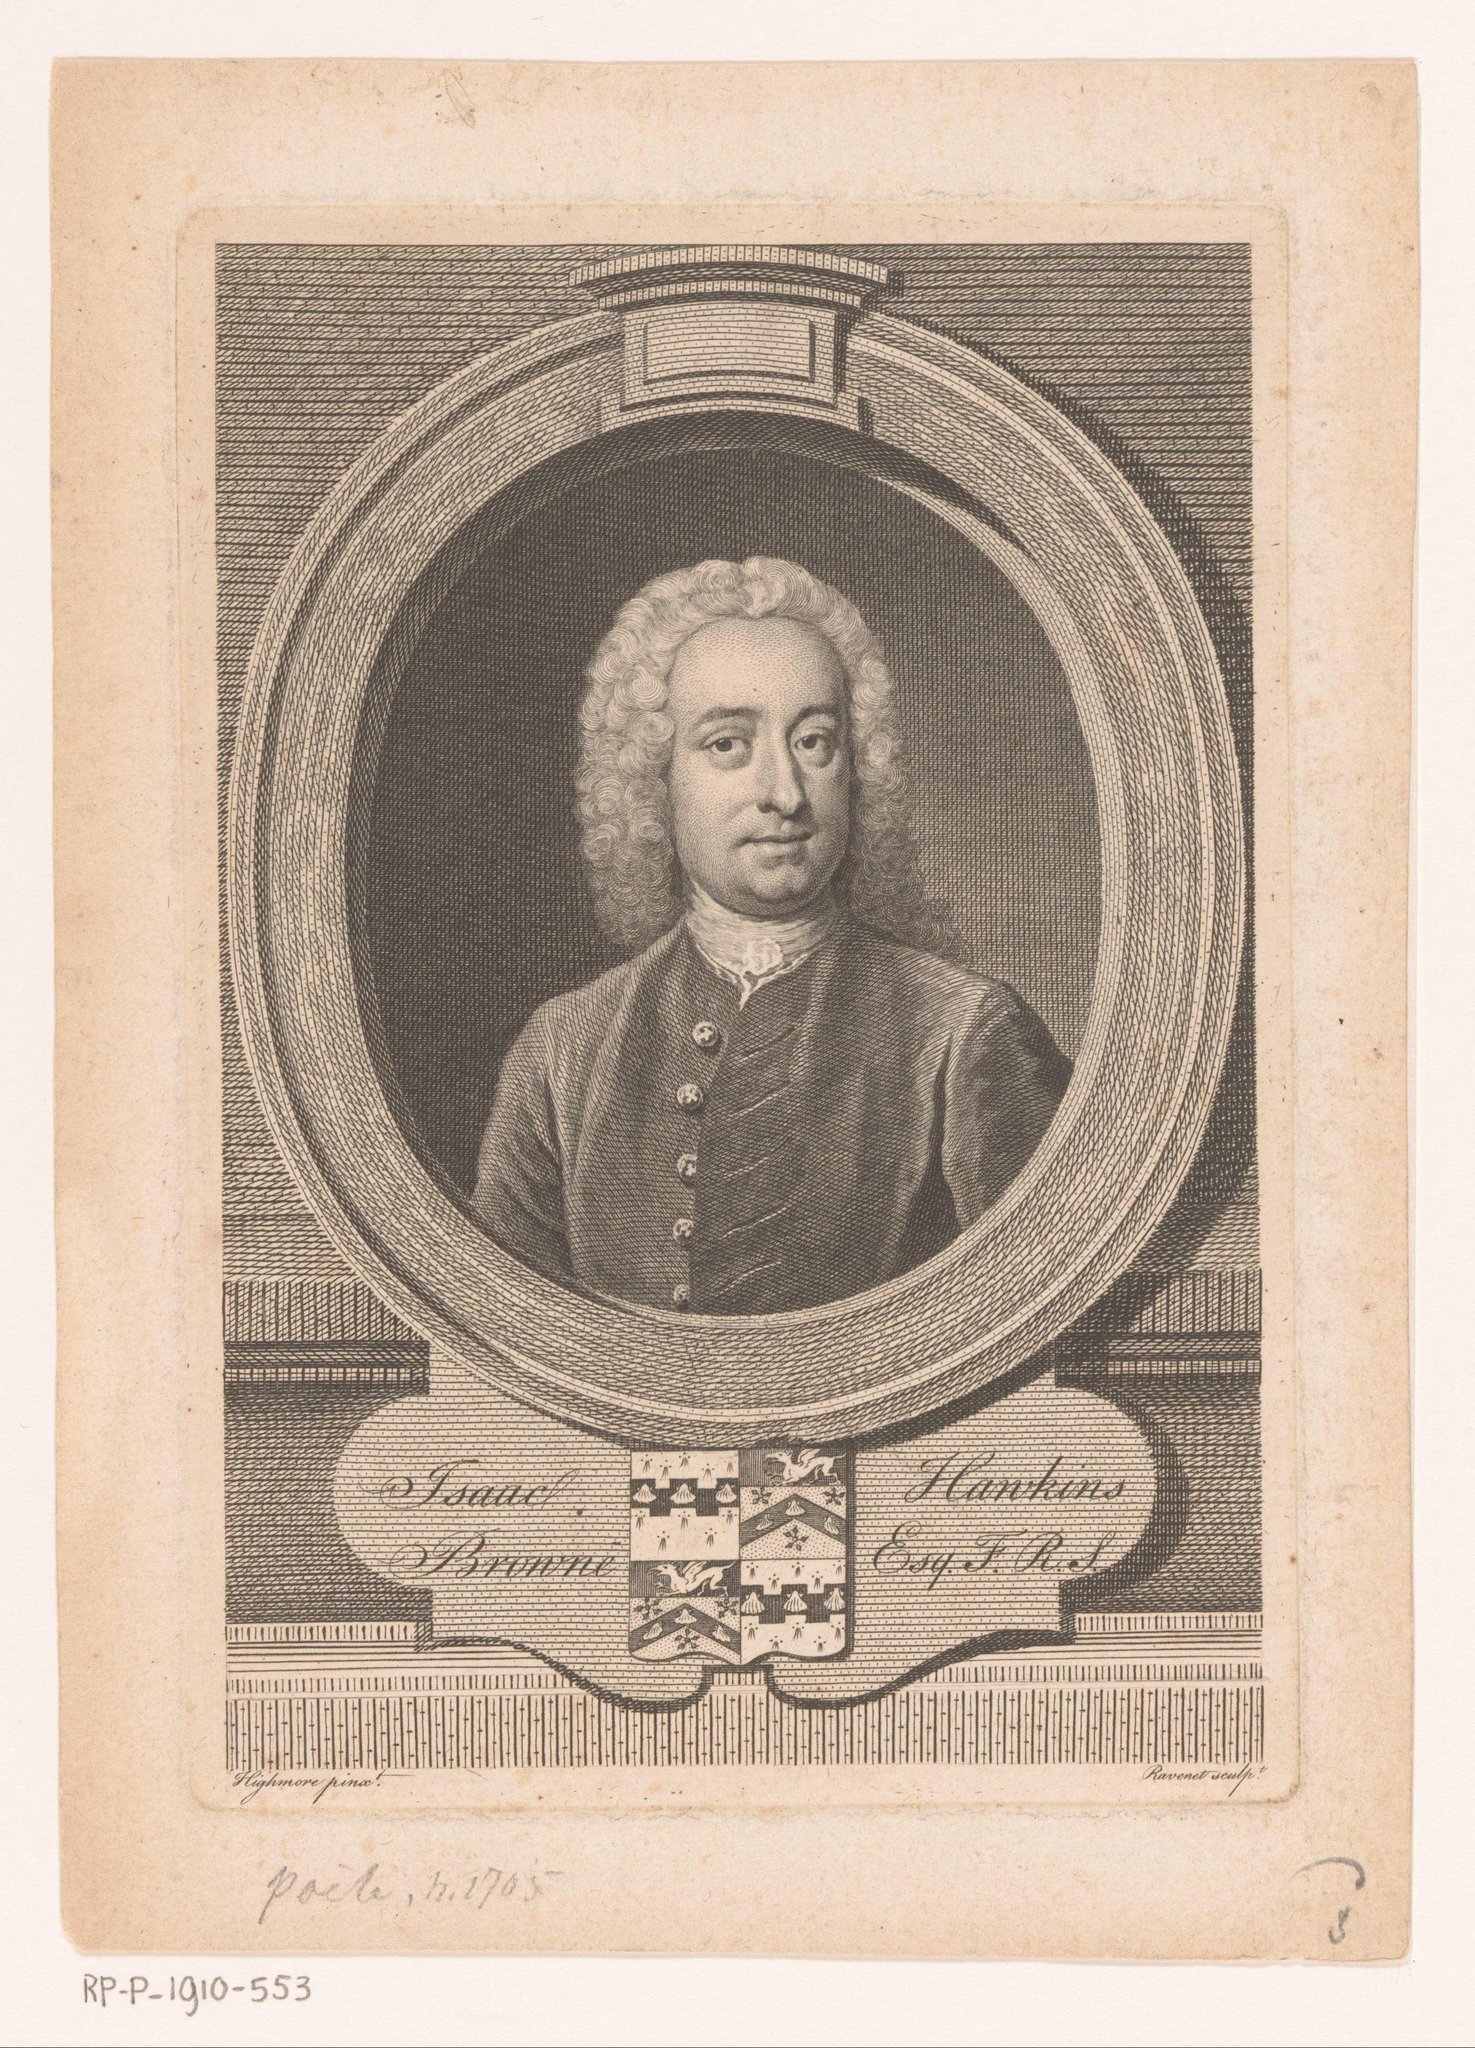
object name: print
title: Portret van Isaac Hawkins Browne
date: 1716-1774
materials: paper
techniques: engraving, etching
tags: london, politician, historical persons, writer, poet, author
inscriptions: collector's mark: Lugt 2228